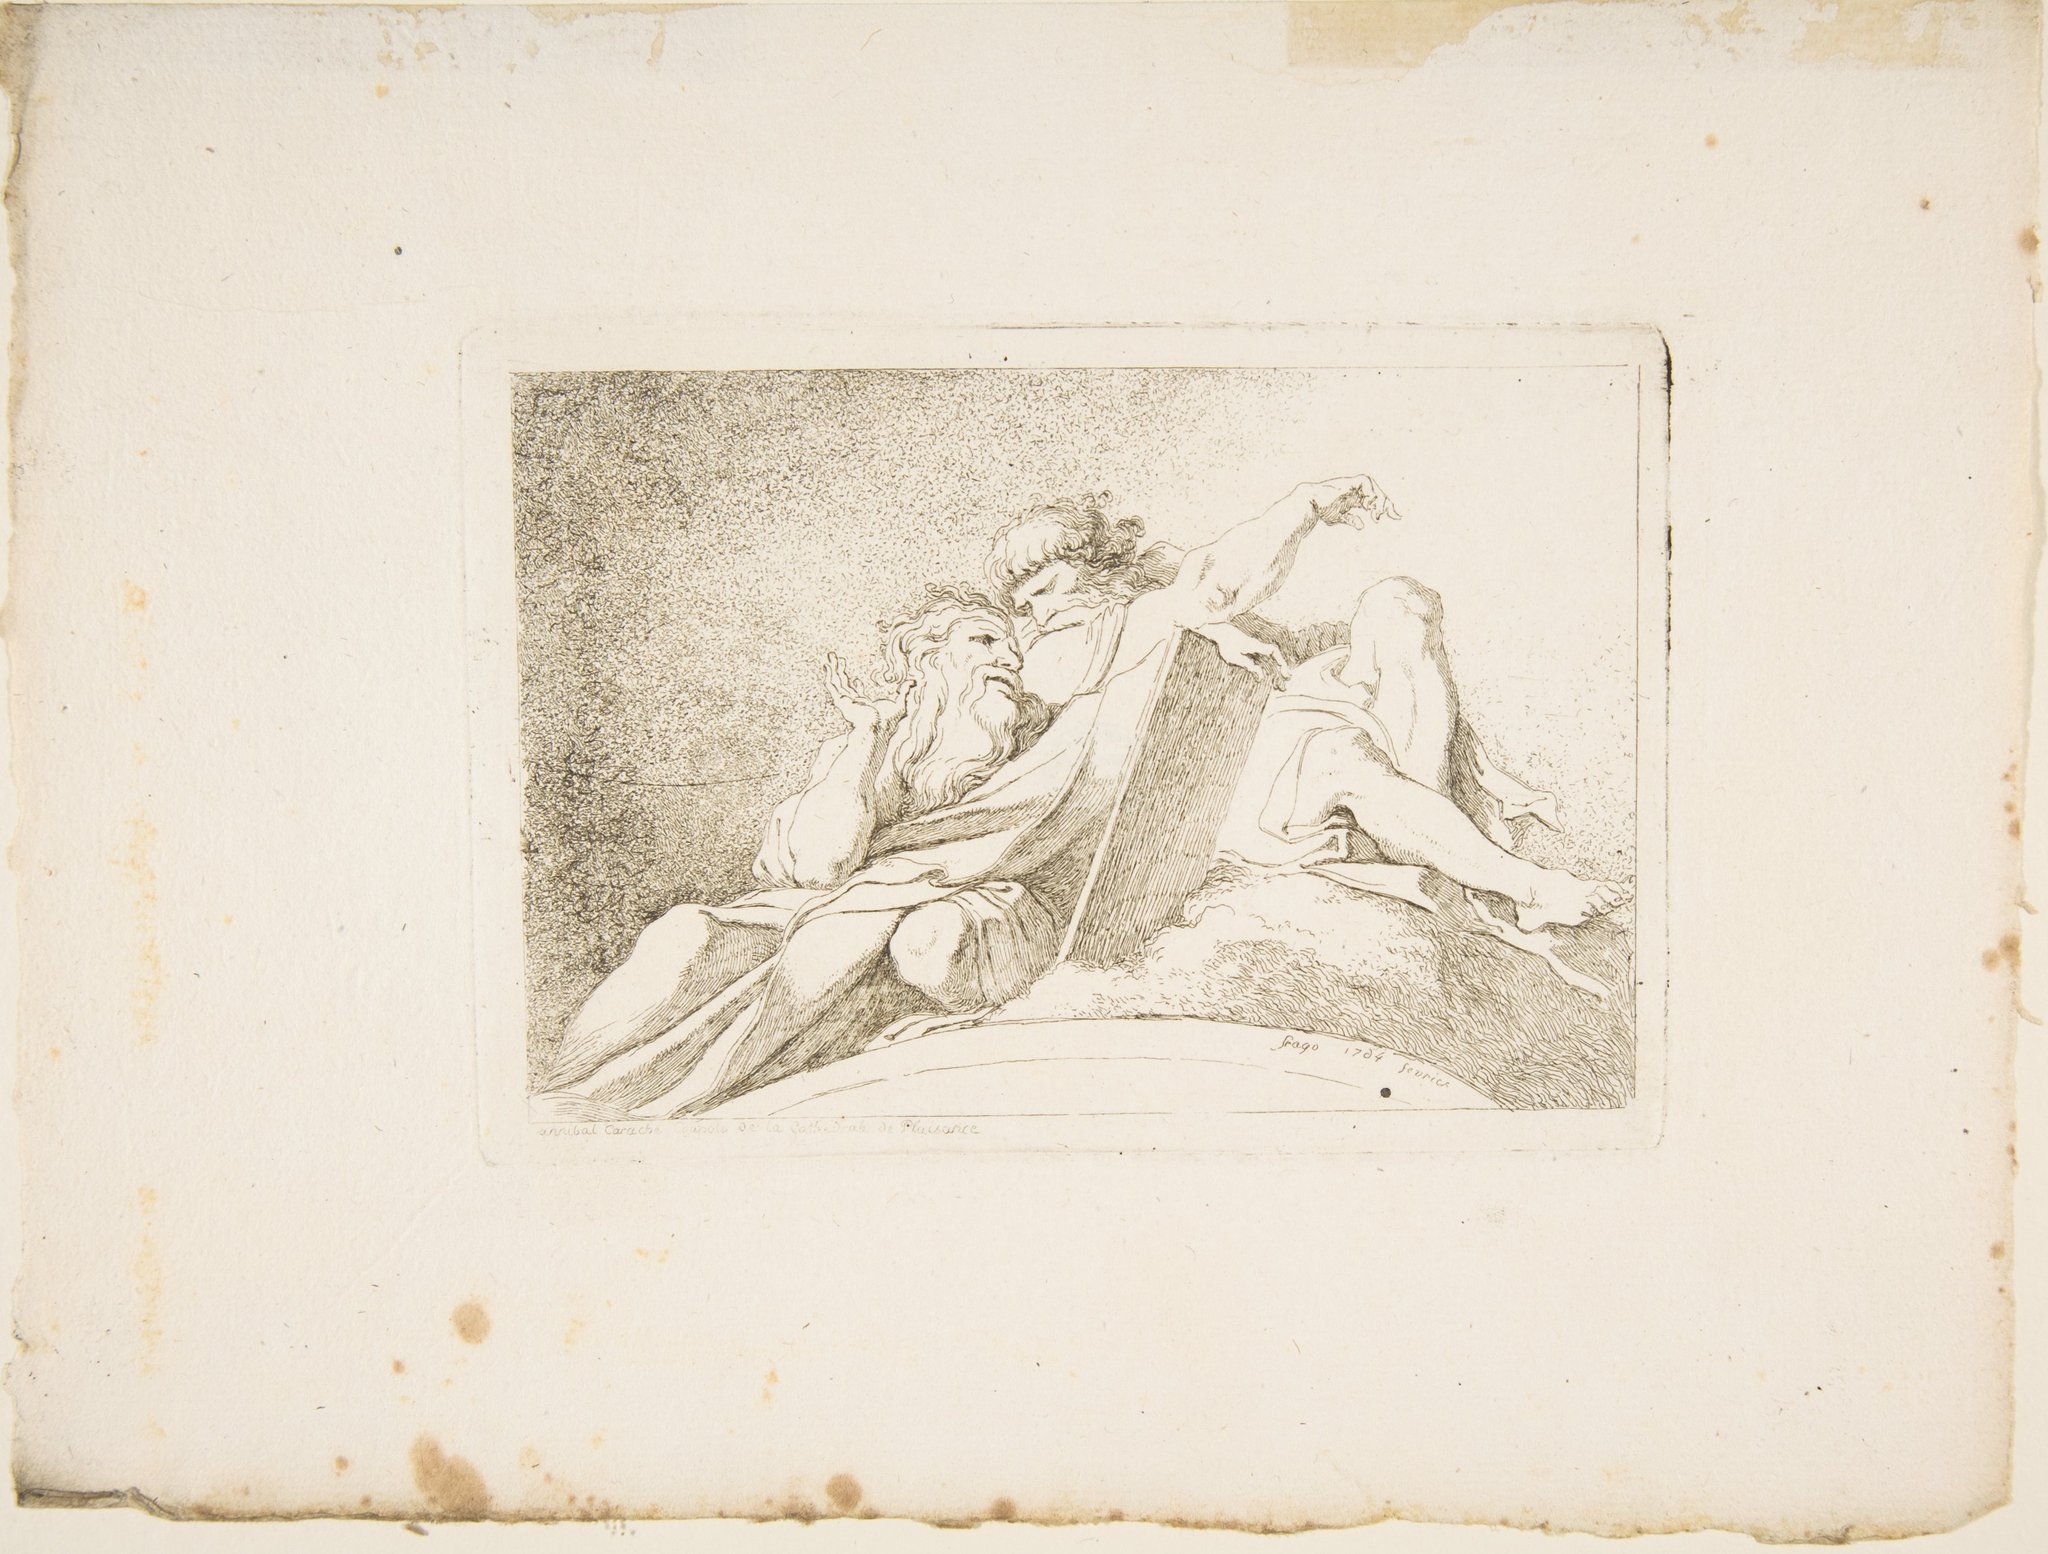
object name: print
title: Moses and a Prophet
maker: jean honoré fragonard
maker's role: artist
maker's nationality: french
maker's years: 1732-1806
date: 1763-1764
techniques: etching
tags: men,moses